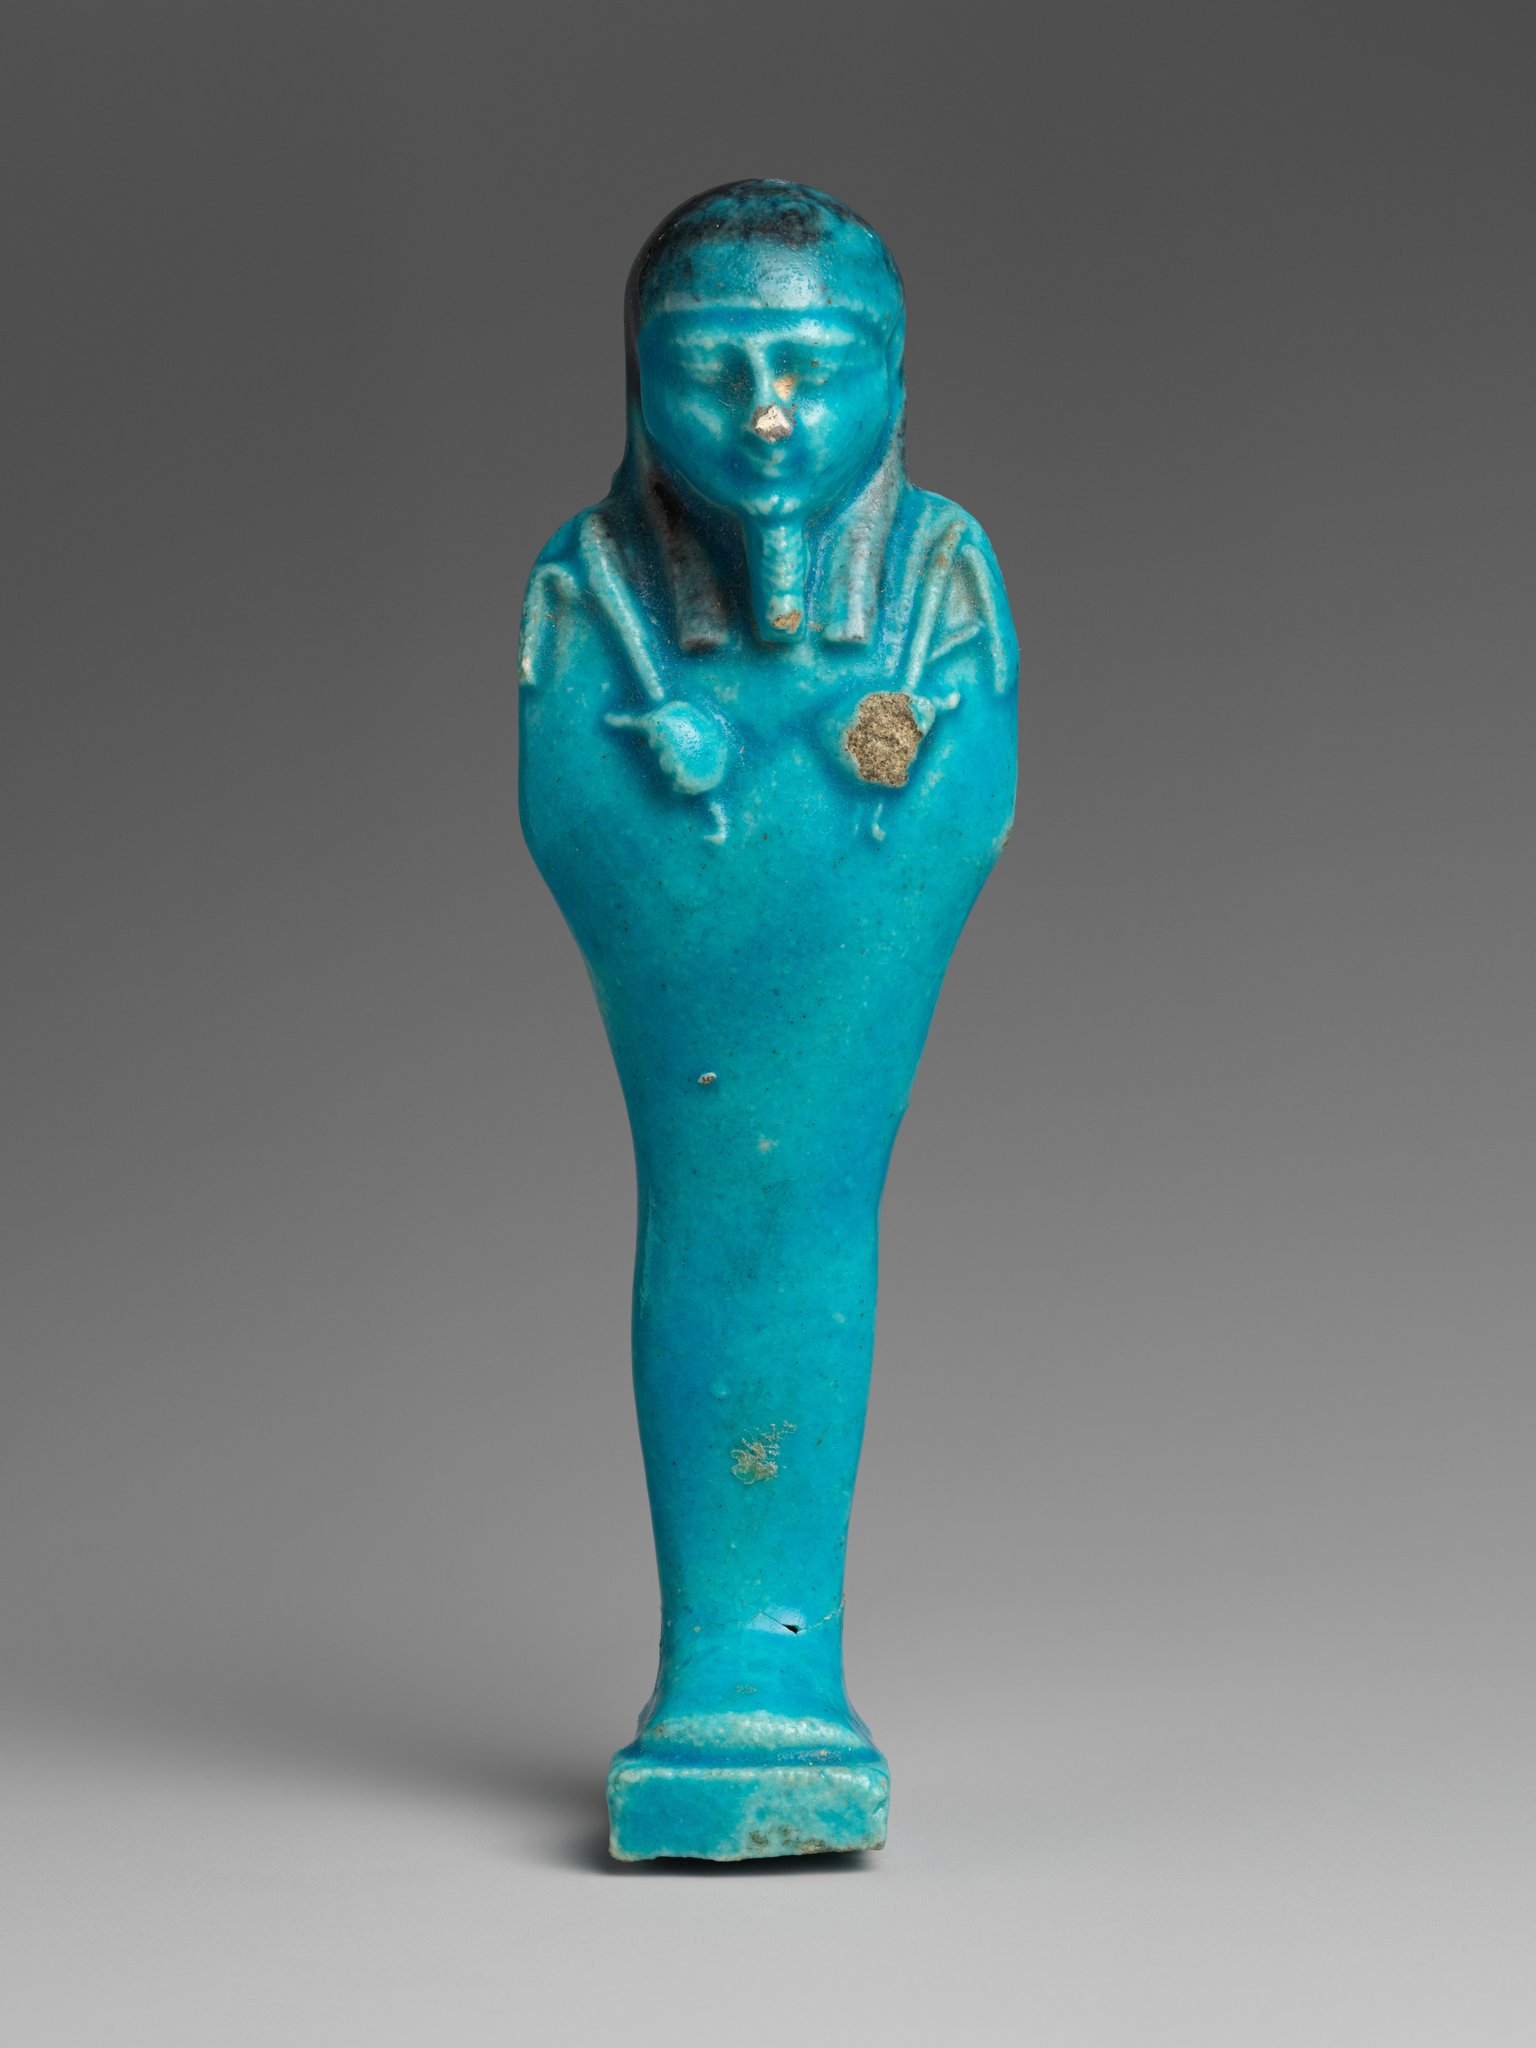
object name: shabti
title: Shabti, uninscribed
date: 664-630 BCE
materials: faience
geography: egypt